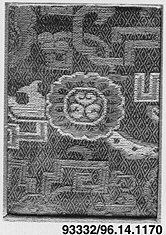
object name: piece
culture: japanese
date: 1701-1900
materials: silk